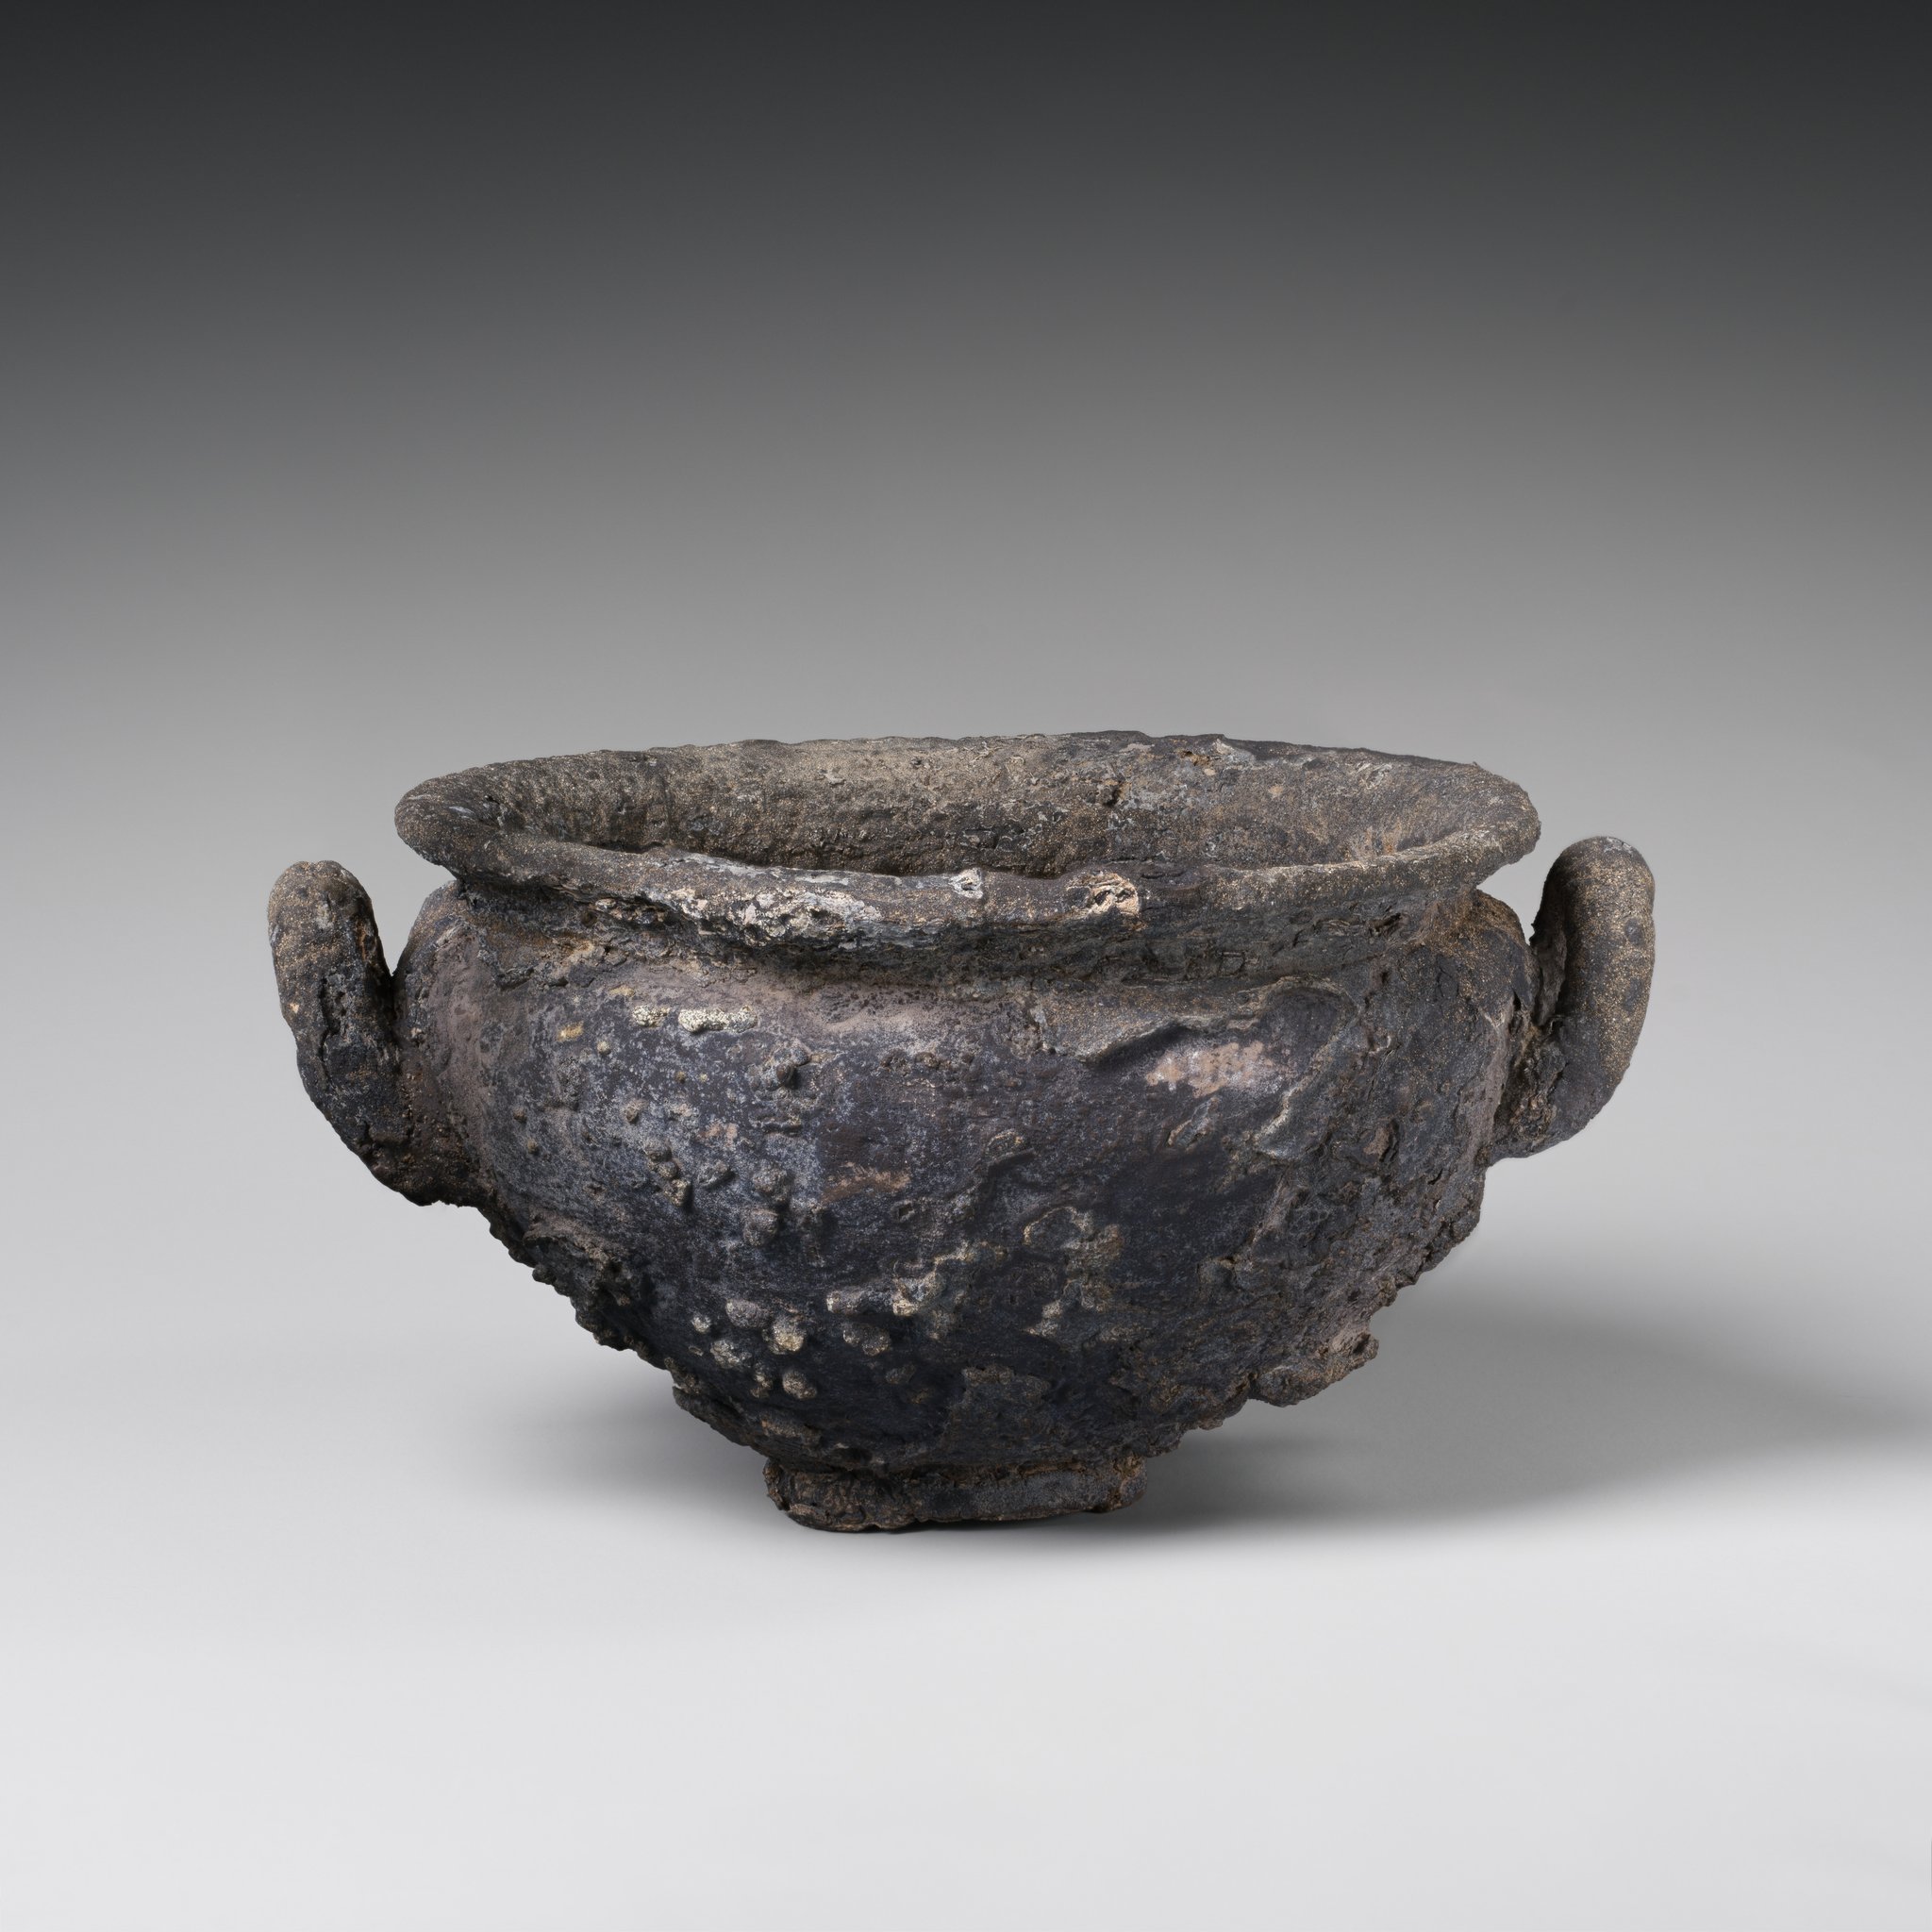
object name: cup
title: Two-handled silver cup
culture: cypriot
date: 700-568 BCE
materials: silver